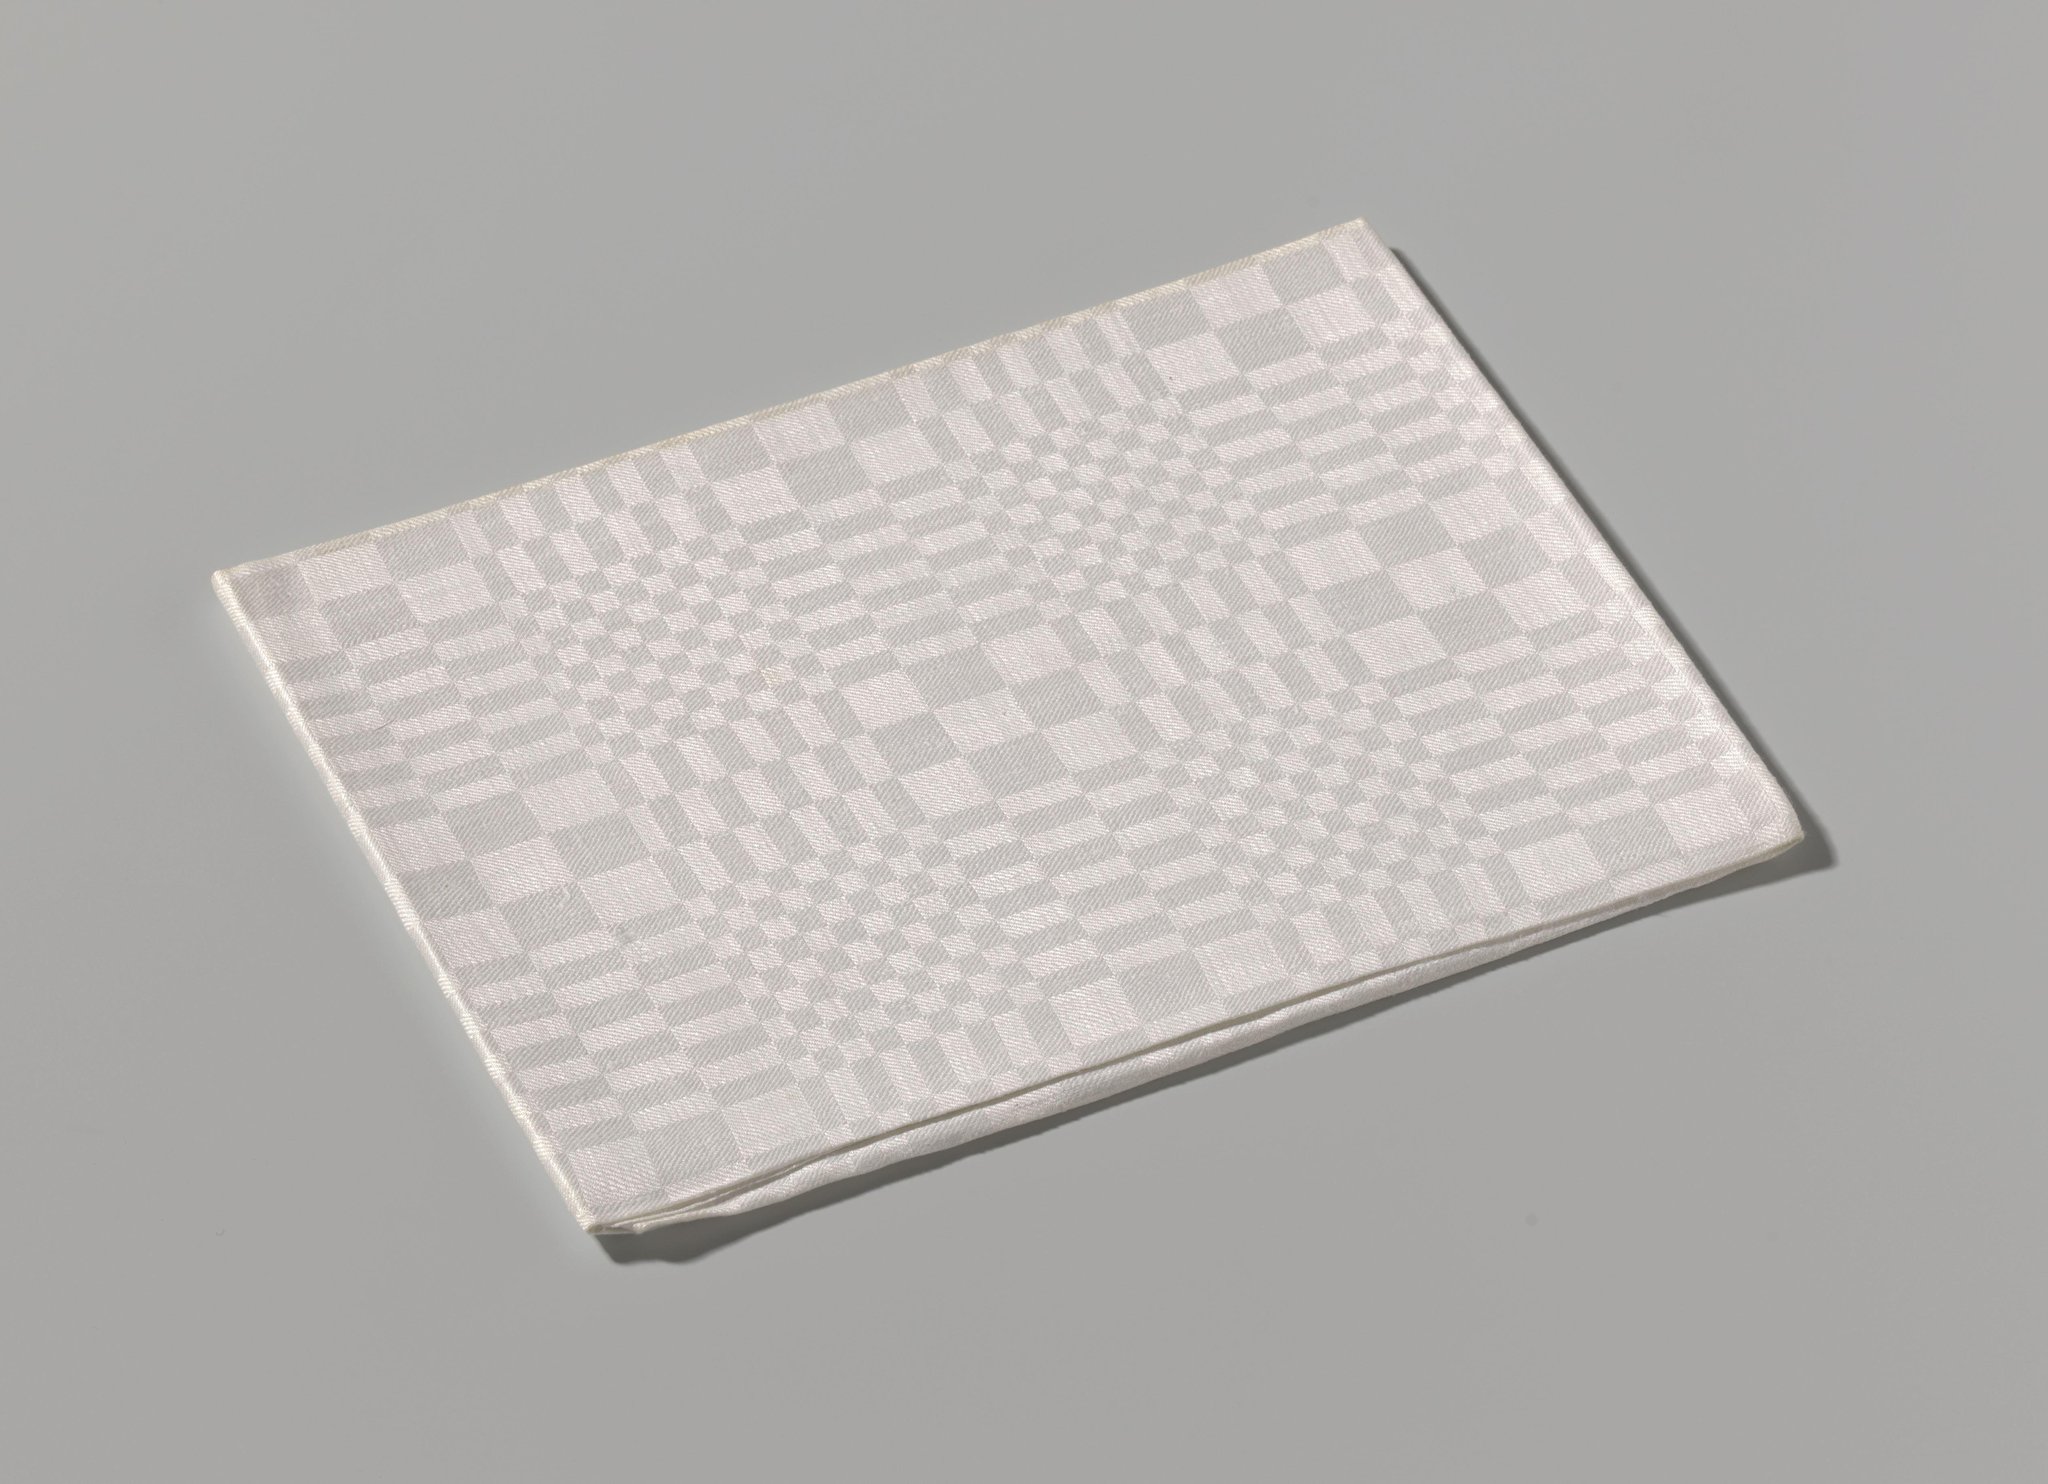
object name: napkin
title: Servet van linnen met pellenpatroon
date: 1784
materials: linen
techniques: twill, peeled fabric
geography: northern netherlands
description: wit linnen servet met pellen patroon, z.g. Engelse garderobe, merk WS 104 en 1784